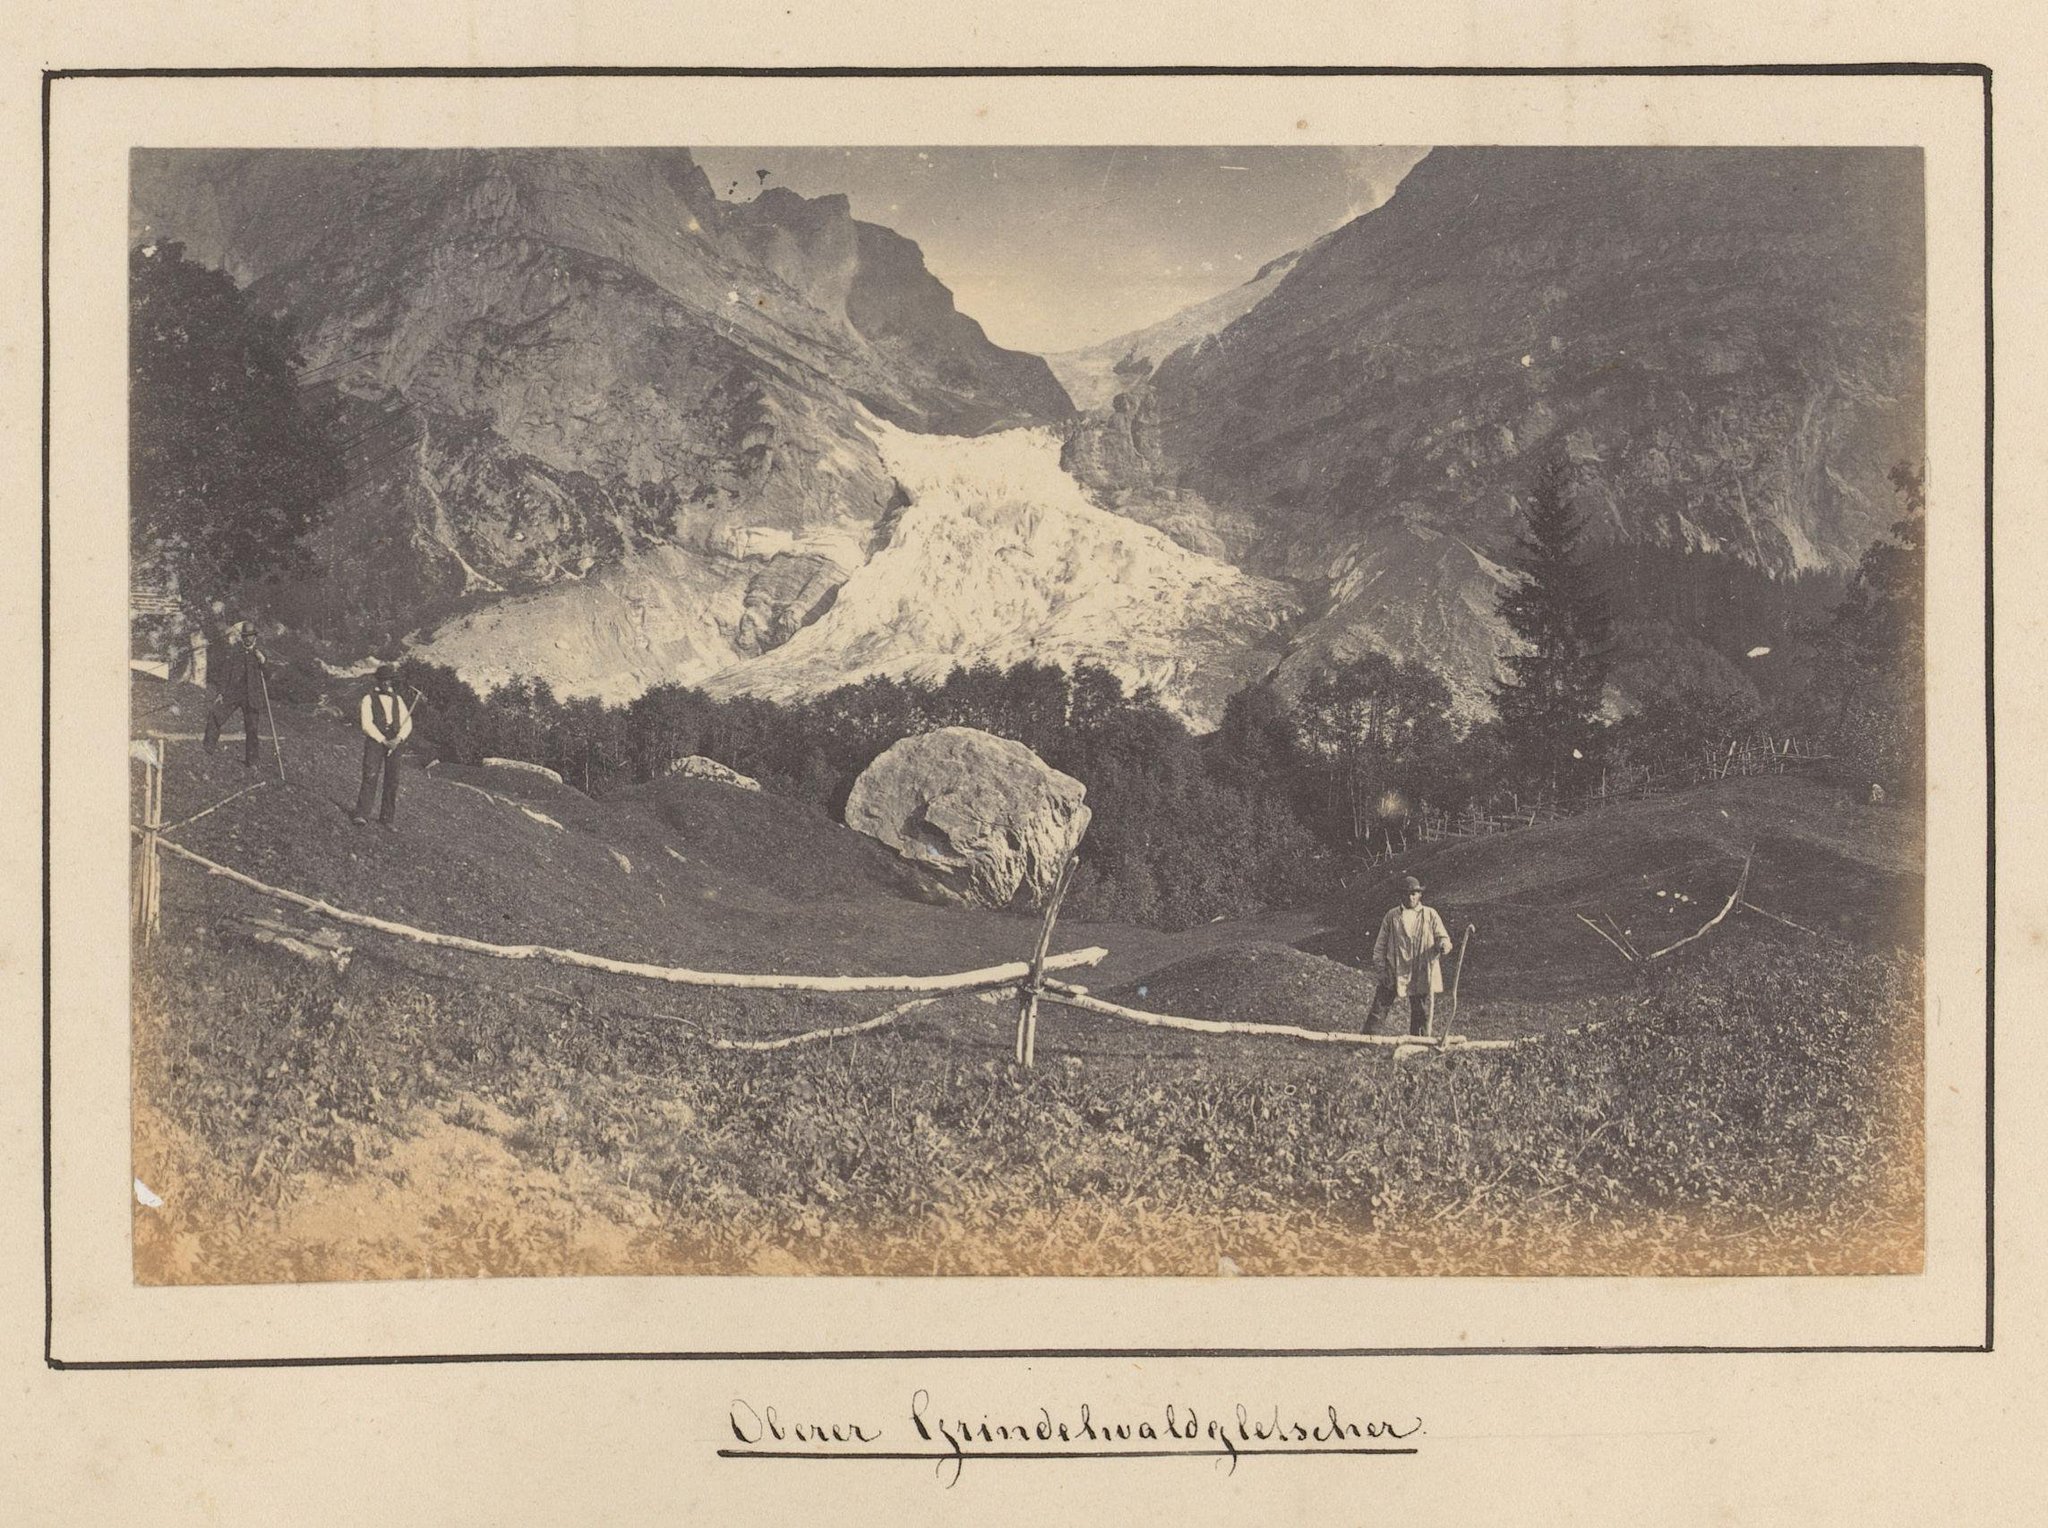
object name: photograph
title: Oberer Grindelwaldgletscher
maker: Anonymous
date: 1870-1890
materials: paper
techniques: albumen print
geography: obere grindelwaldgletsjer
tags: glacier, mountains